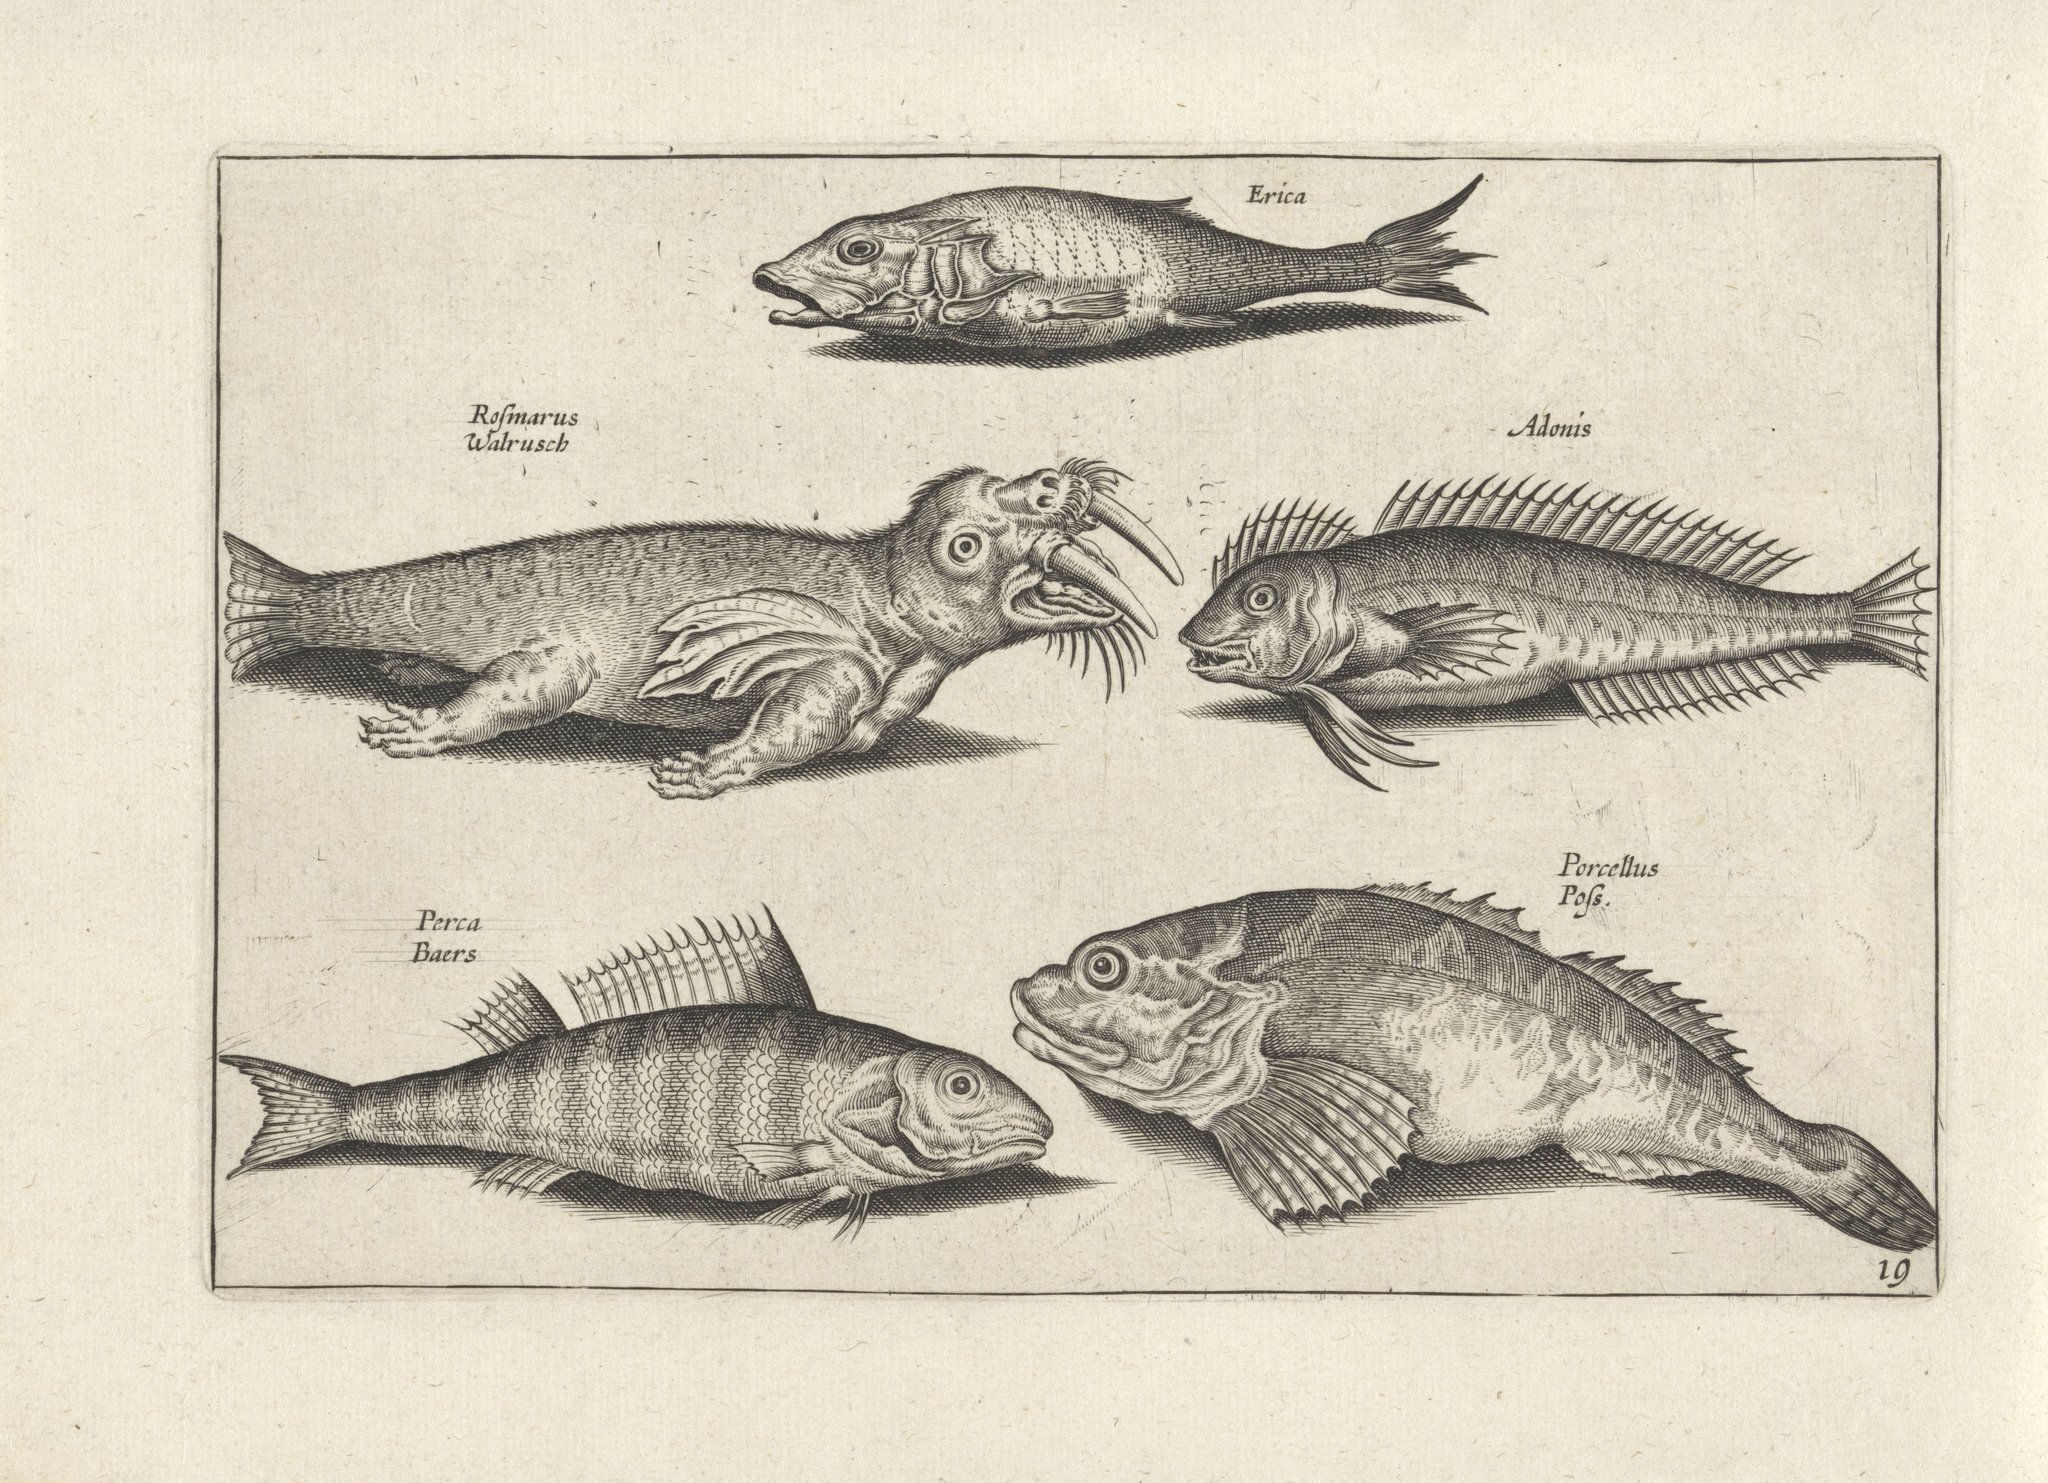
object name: print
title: Piscium Vivae Icones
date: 1634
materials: paper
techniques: engraving, etching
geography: amsterdam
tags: fishes, swimming mammals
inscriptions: collector's mark: Lugt 240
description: Vier verschillende vissen, waaronder een baars en een walrus. Elke vis is voorzien van zijn naam. De prent maakt deel uit van een serie met vissen als onderwerp.